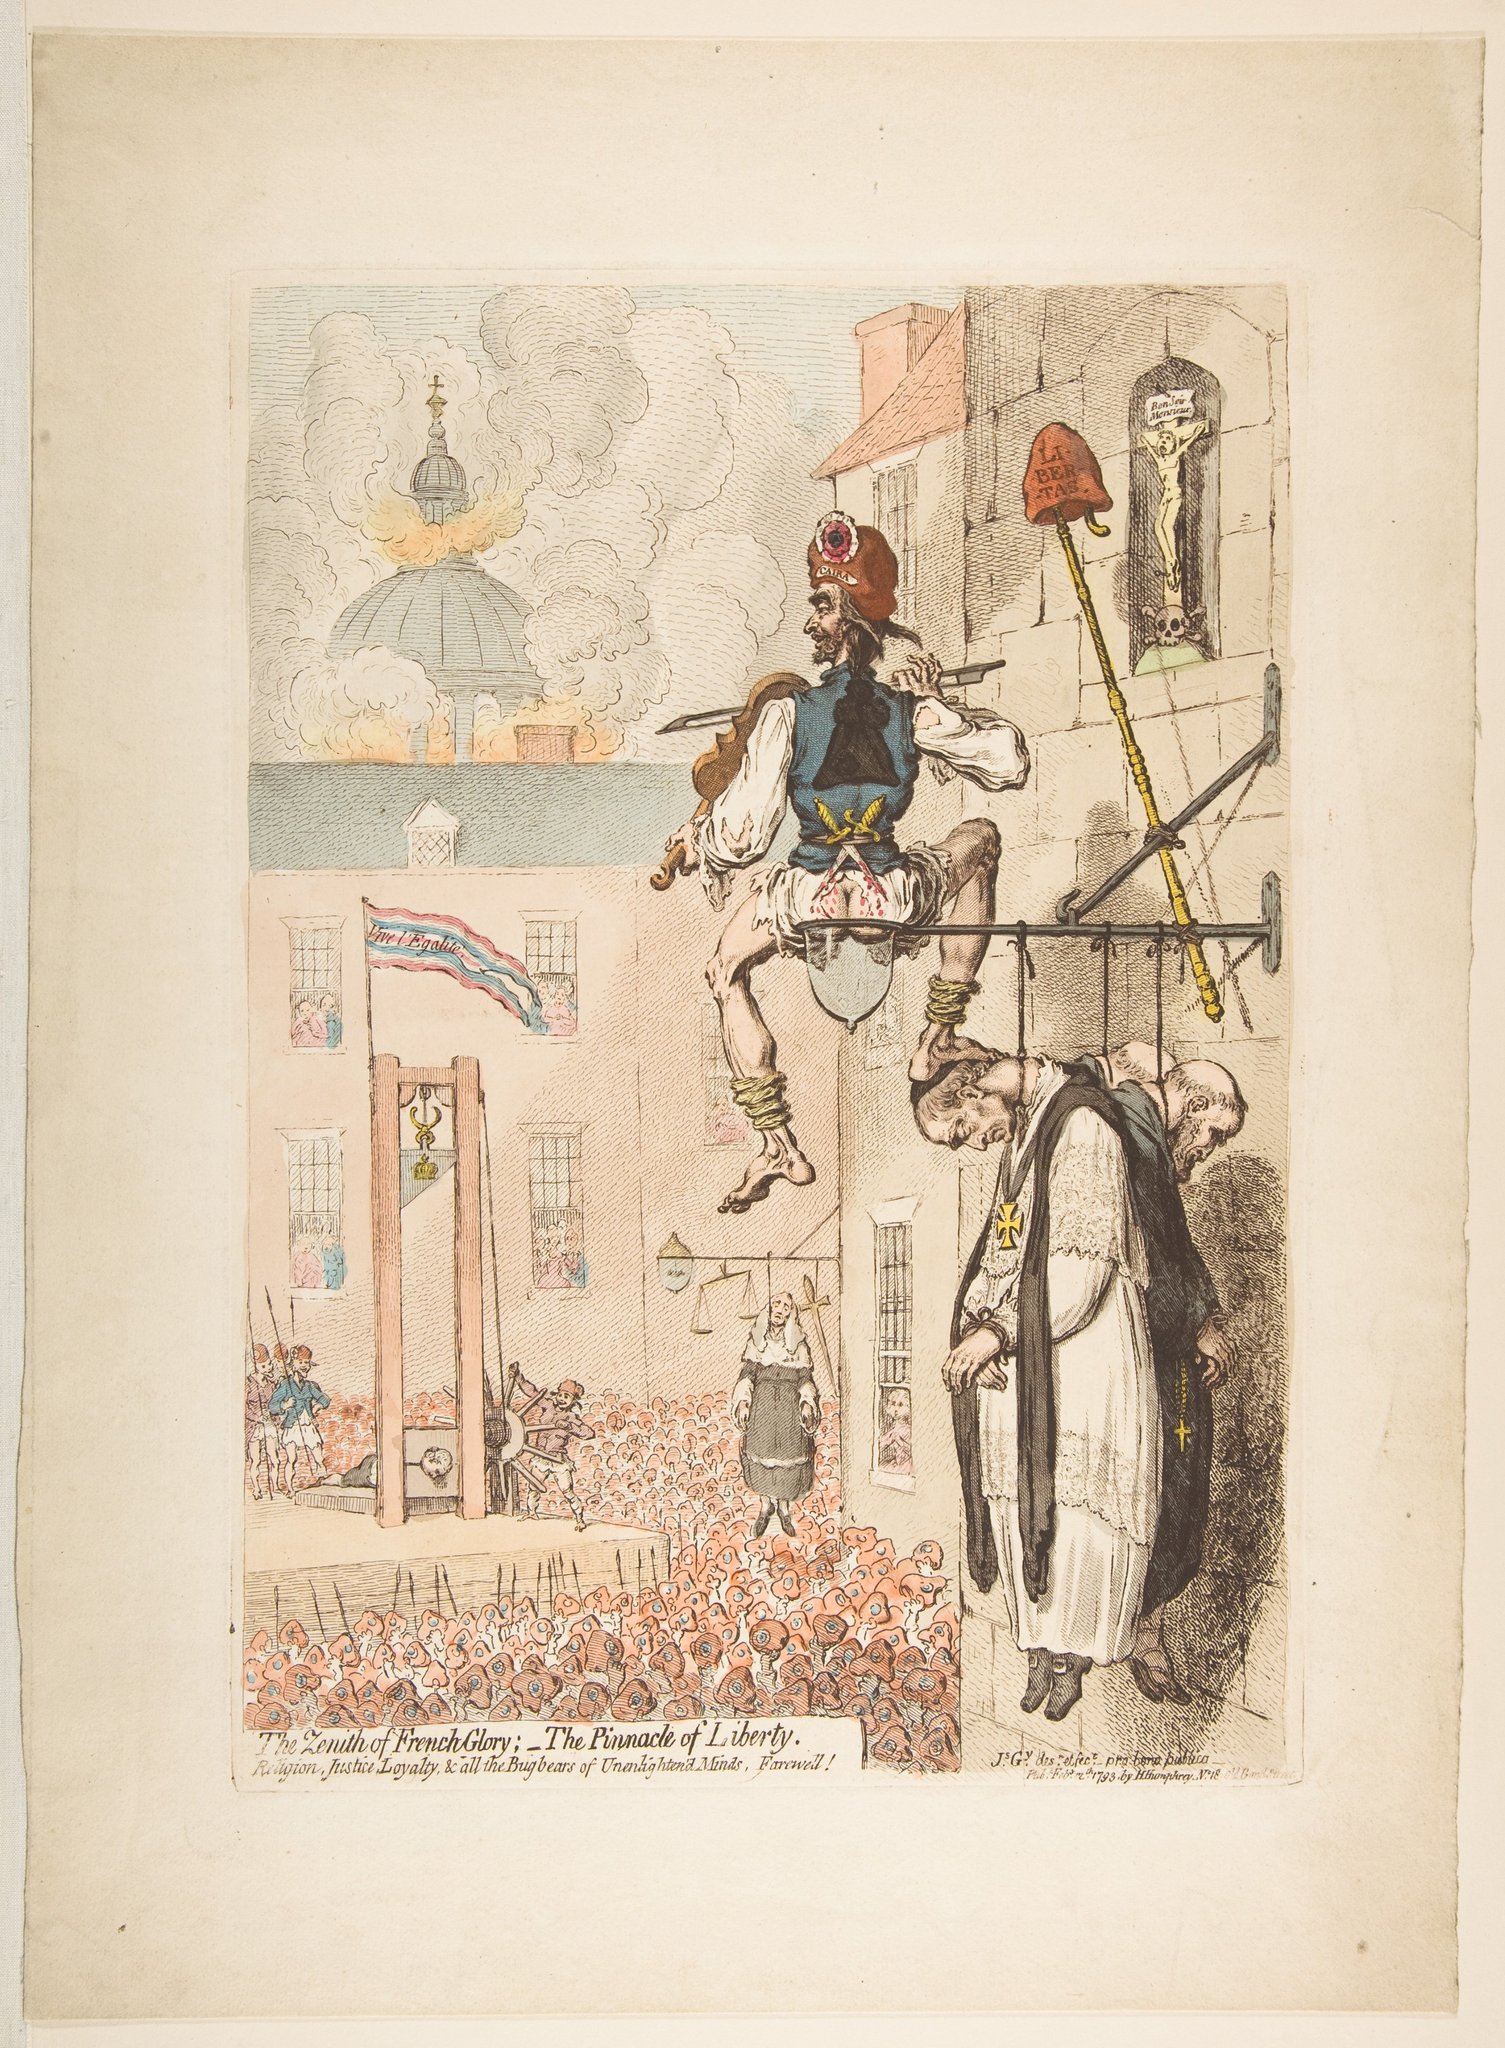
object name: print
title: The Zenith of French Glory; – The Pinnacle of Liberty. Religion, Justice, Loyalty, & all the Bugbears of Unenlightened Minds, Farewell!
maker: james gillray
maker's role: artist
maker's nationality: british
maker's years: 1756-1815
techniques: engraving, etching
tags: satire,french revolution,men,crowd,execution